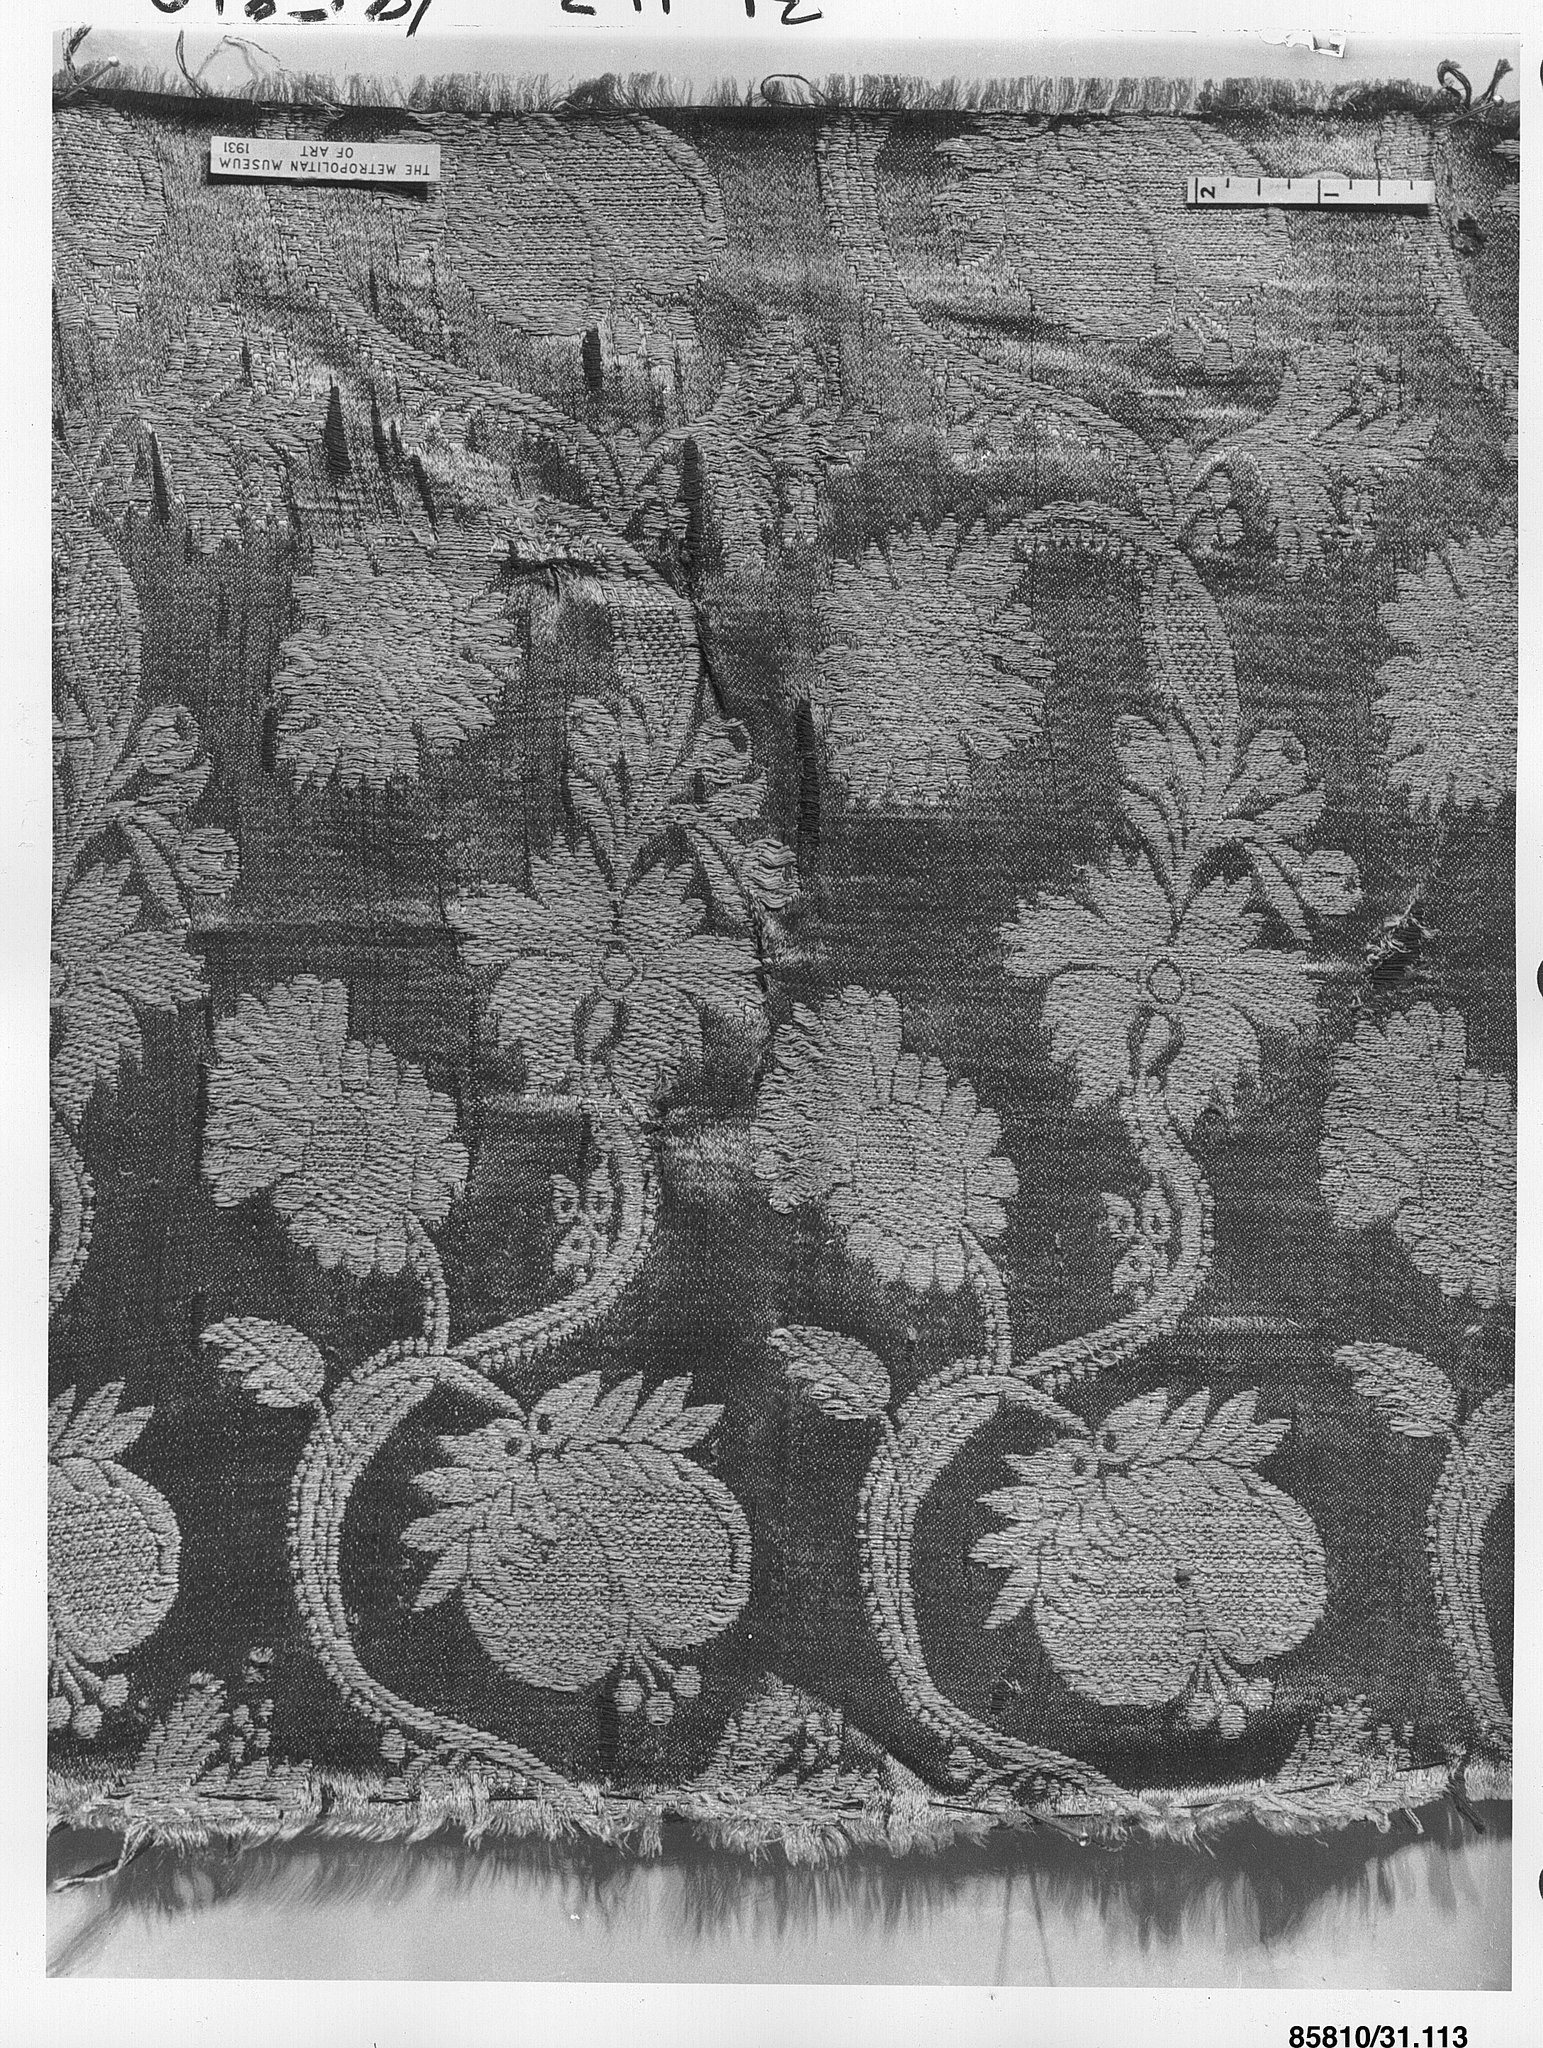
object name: piece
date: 1701-1900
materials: linen, metal thread, silk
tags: leaves